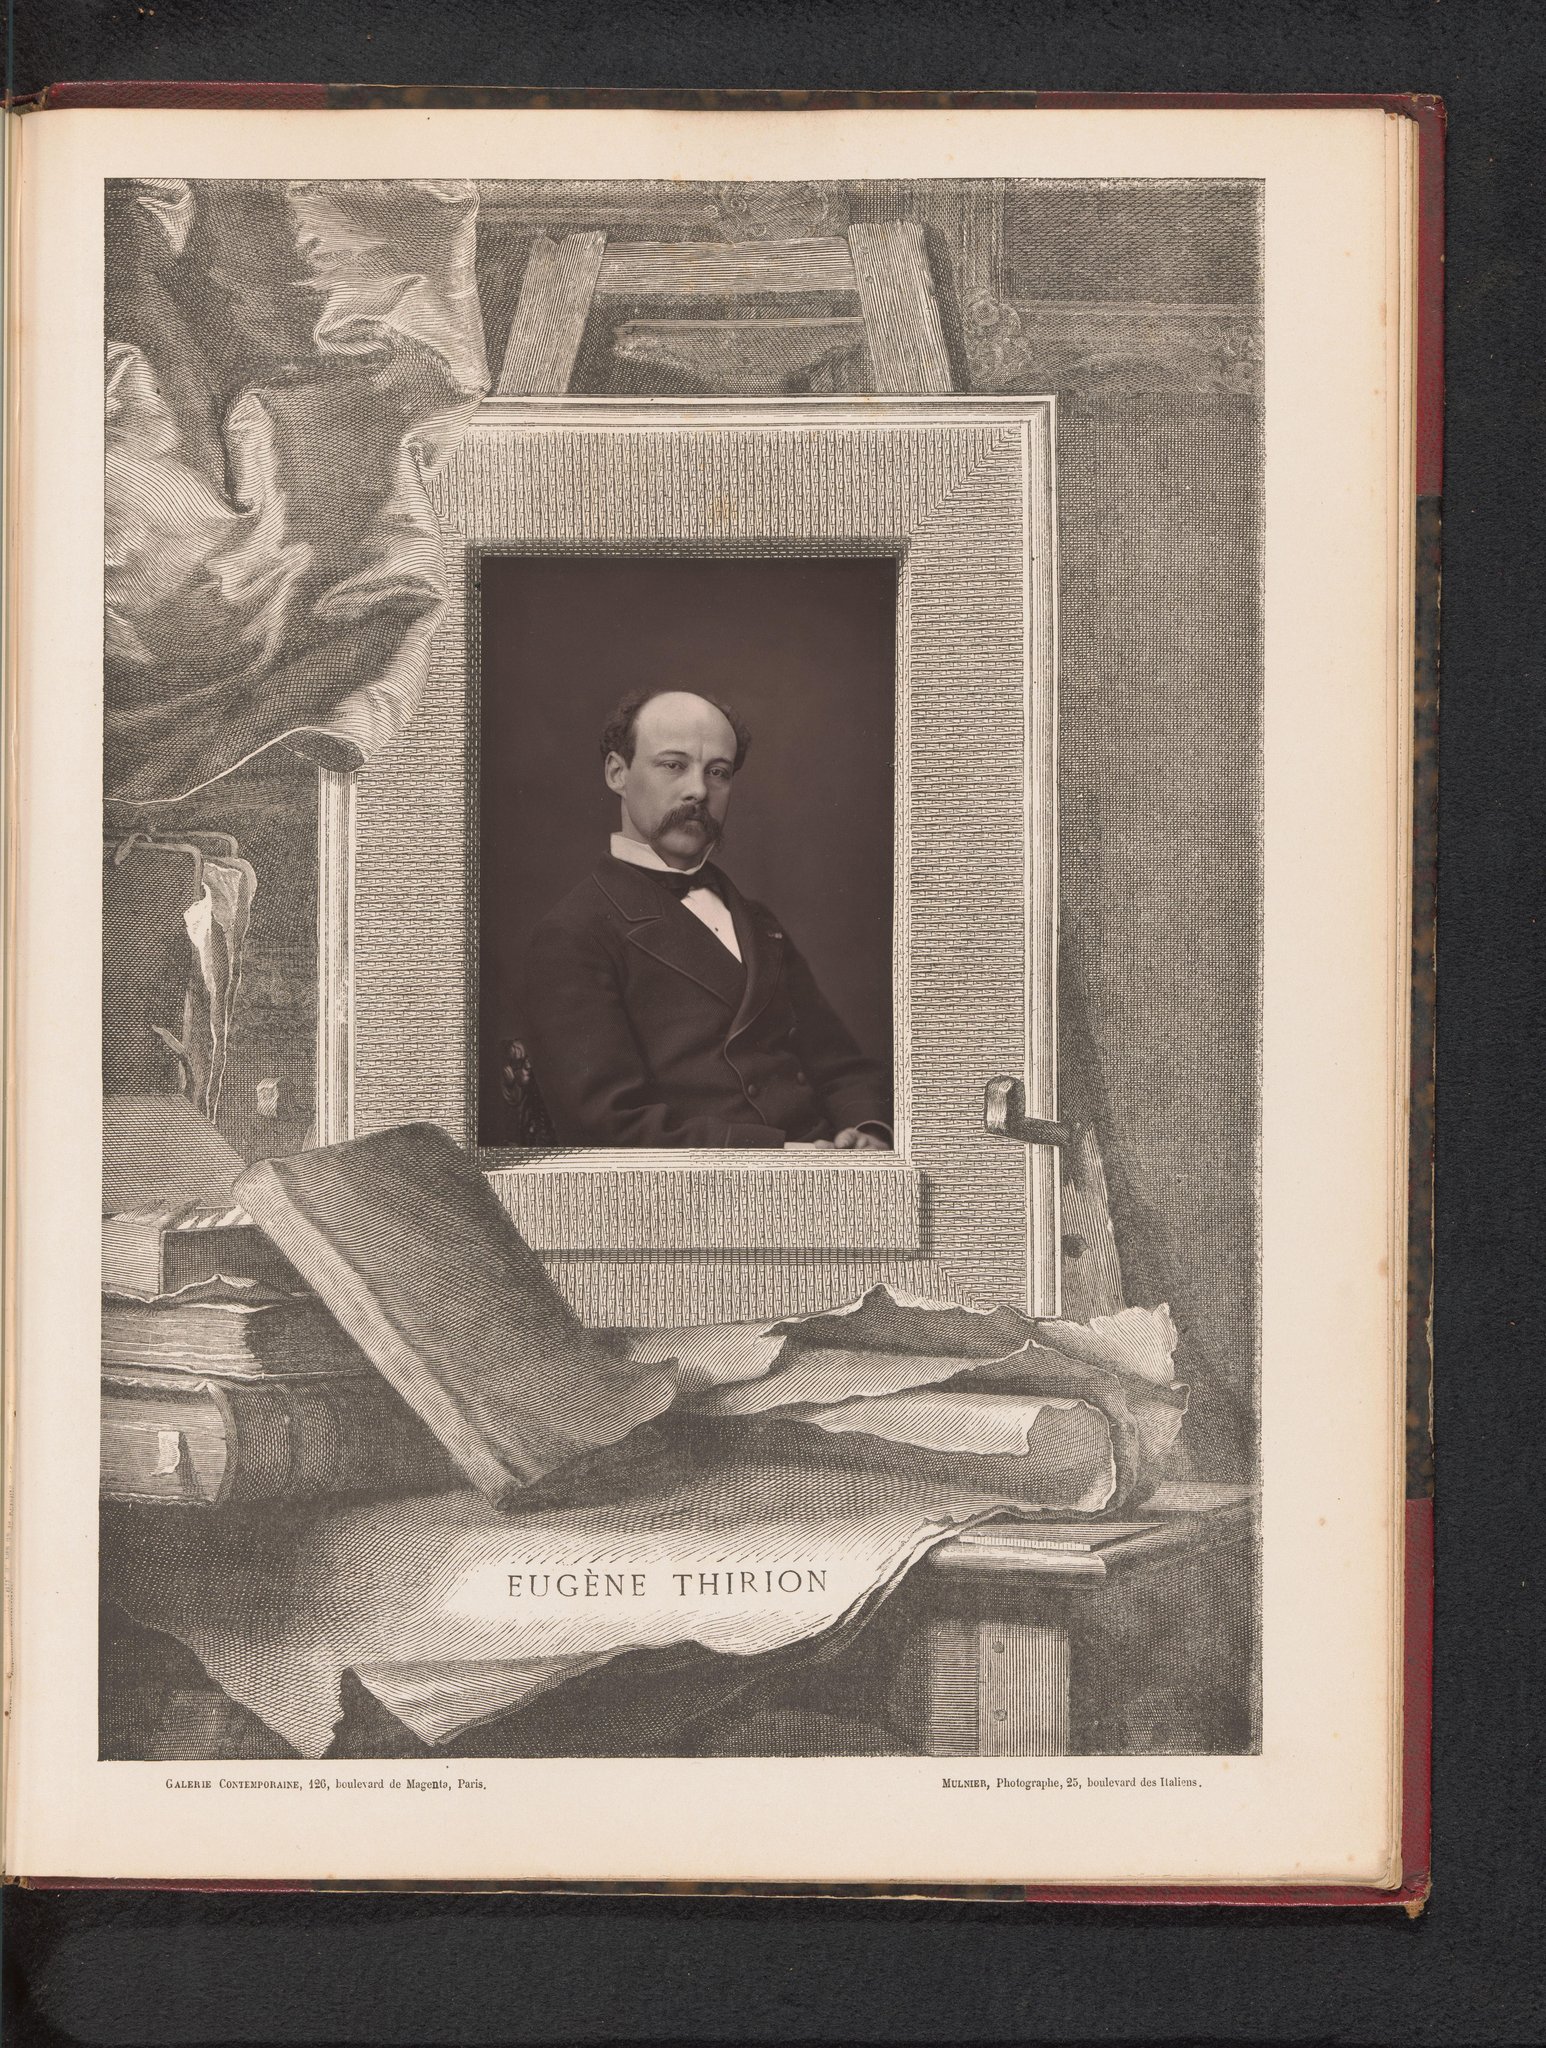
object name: page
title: Eugène Thirion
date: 1871-1876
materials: paper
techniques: woodburytype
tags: paris, painter, draughtsman, eugène romain thirion, adult man, historical persons